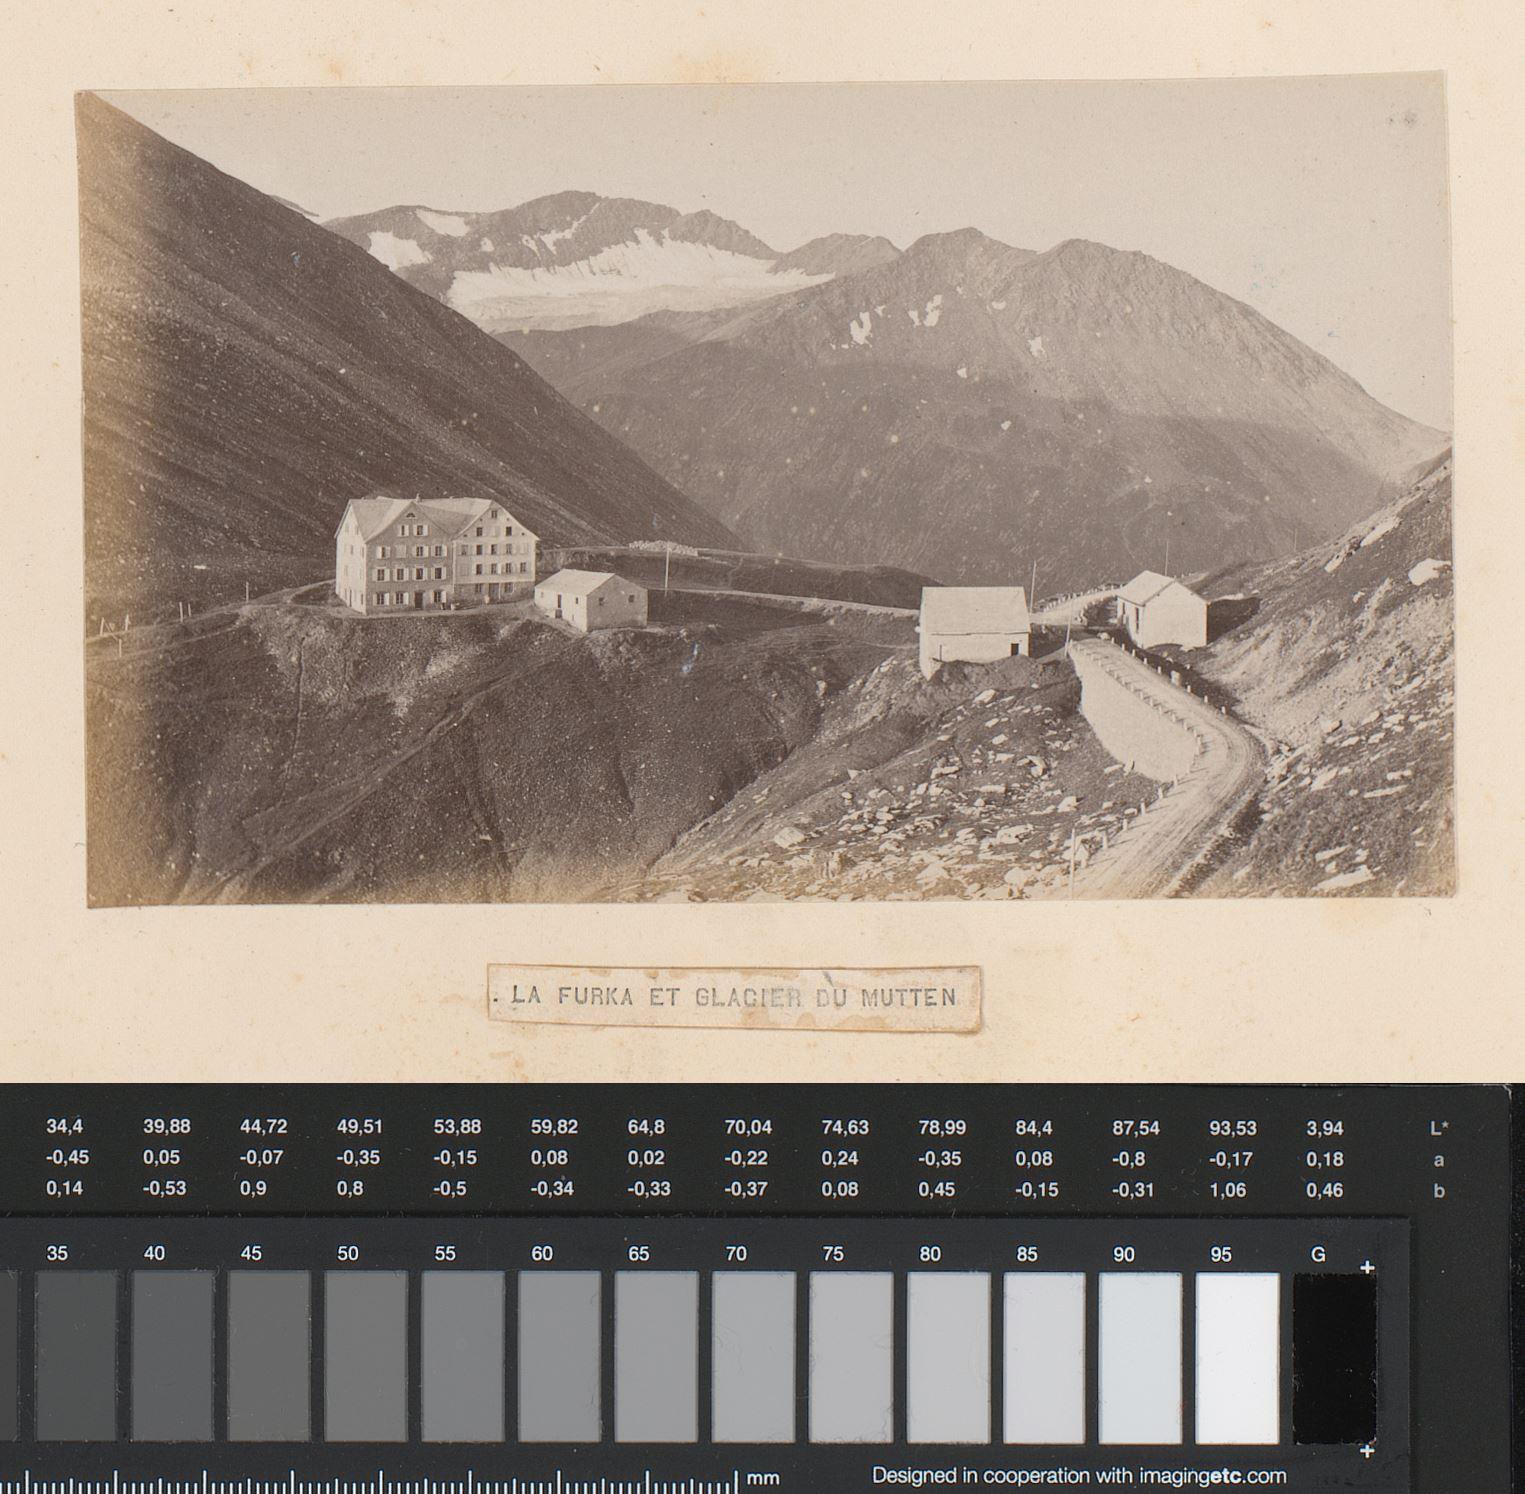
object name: photograph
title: La Furka et Glacier du Mutten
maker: Anonymous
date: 1860-1890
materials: paper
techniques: albumen print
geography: furkapas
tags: road, path, exterior ~ representation of a building, mountains